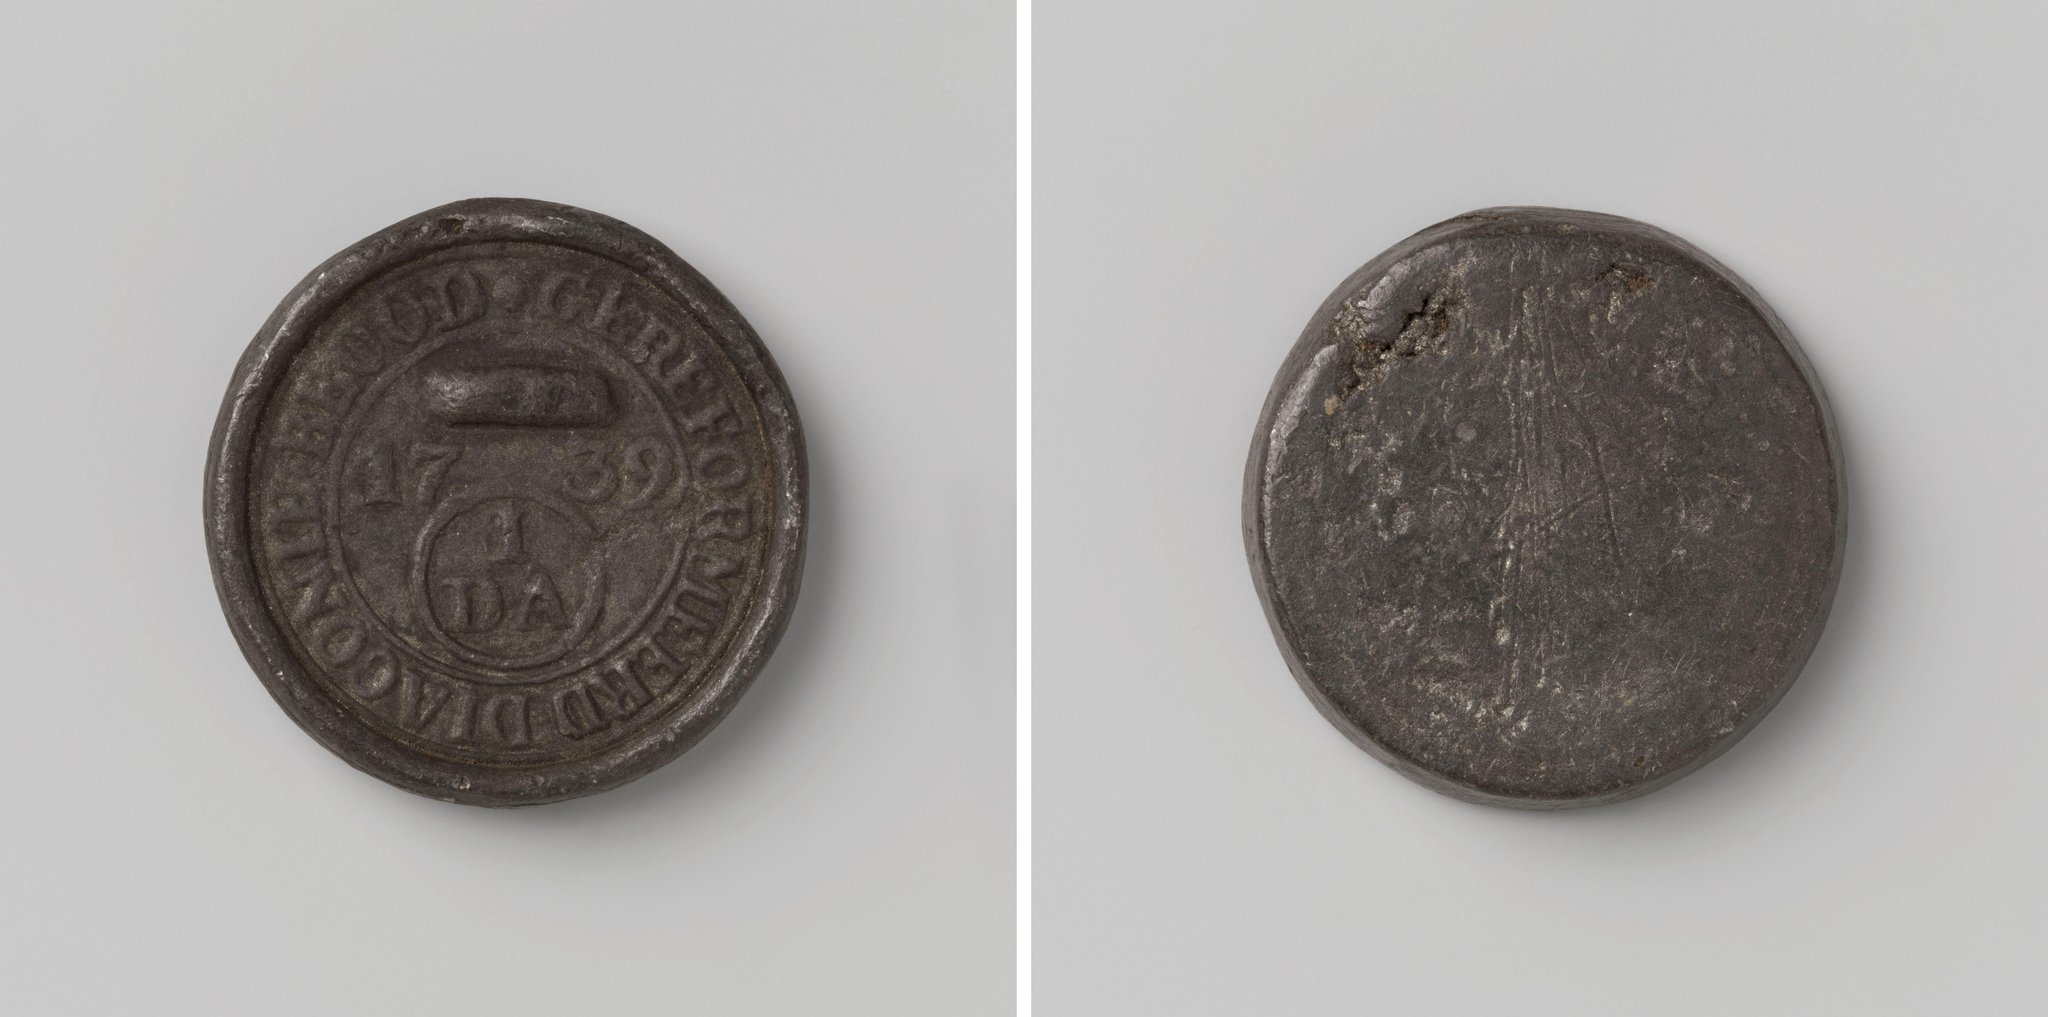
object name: broodpenning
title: Gereformeerde Diakonie te Amsterdam, armenpenning die behoeftige kerklidmaten bij uitdeling recht gaf op brood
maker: Anonymous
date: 1739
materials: lead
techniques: casting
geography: amsterdam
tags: amsterdam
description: Enkelzijdige loden penning. Voorzijde: rechthoekig brood boven jaartal en letters DIA in krans binnen omschrift. Keerzijde: blanco